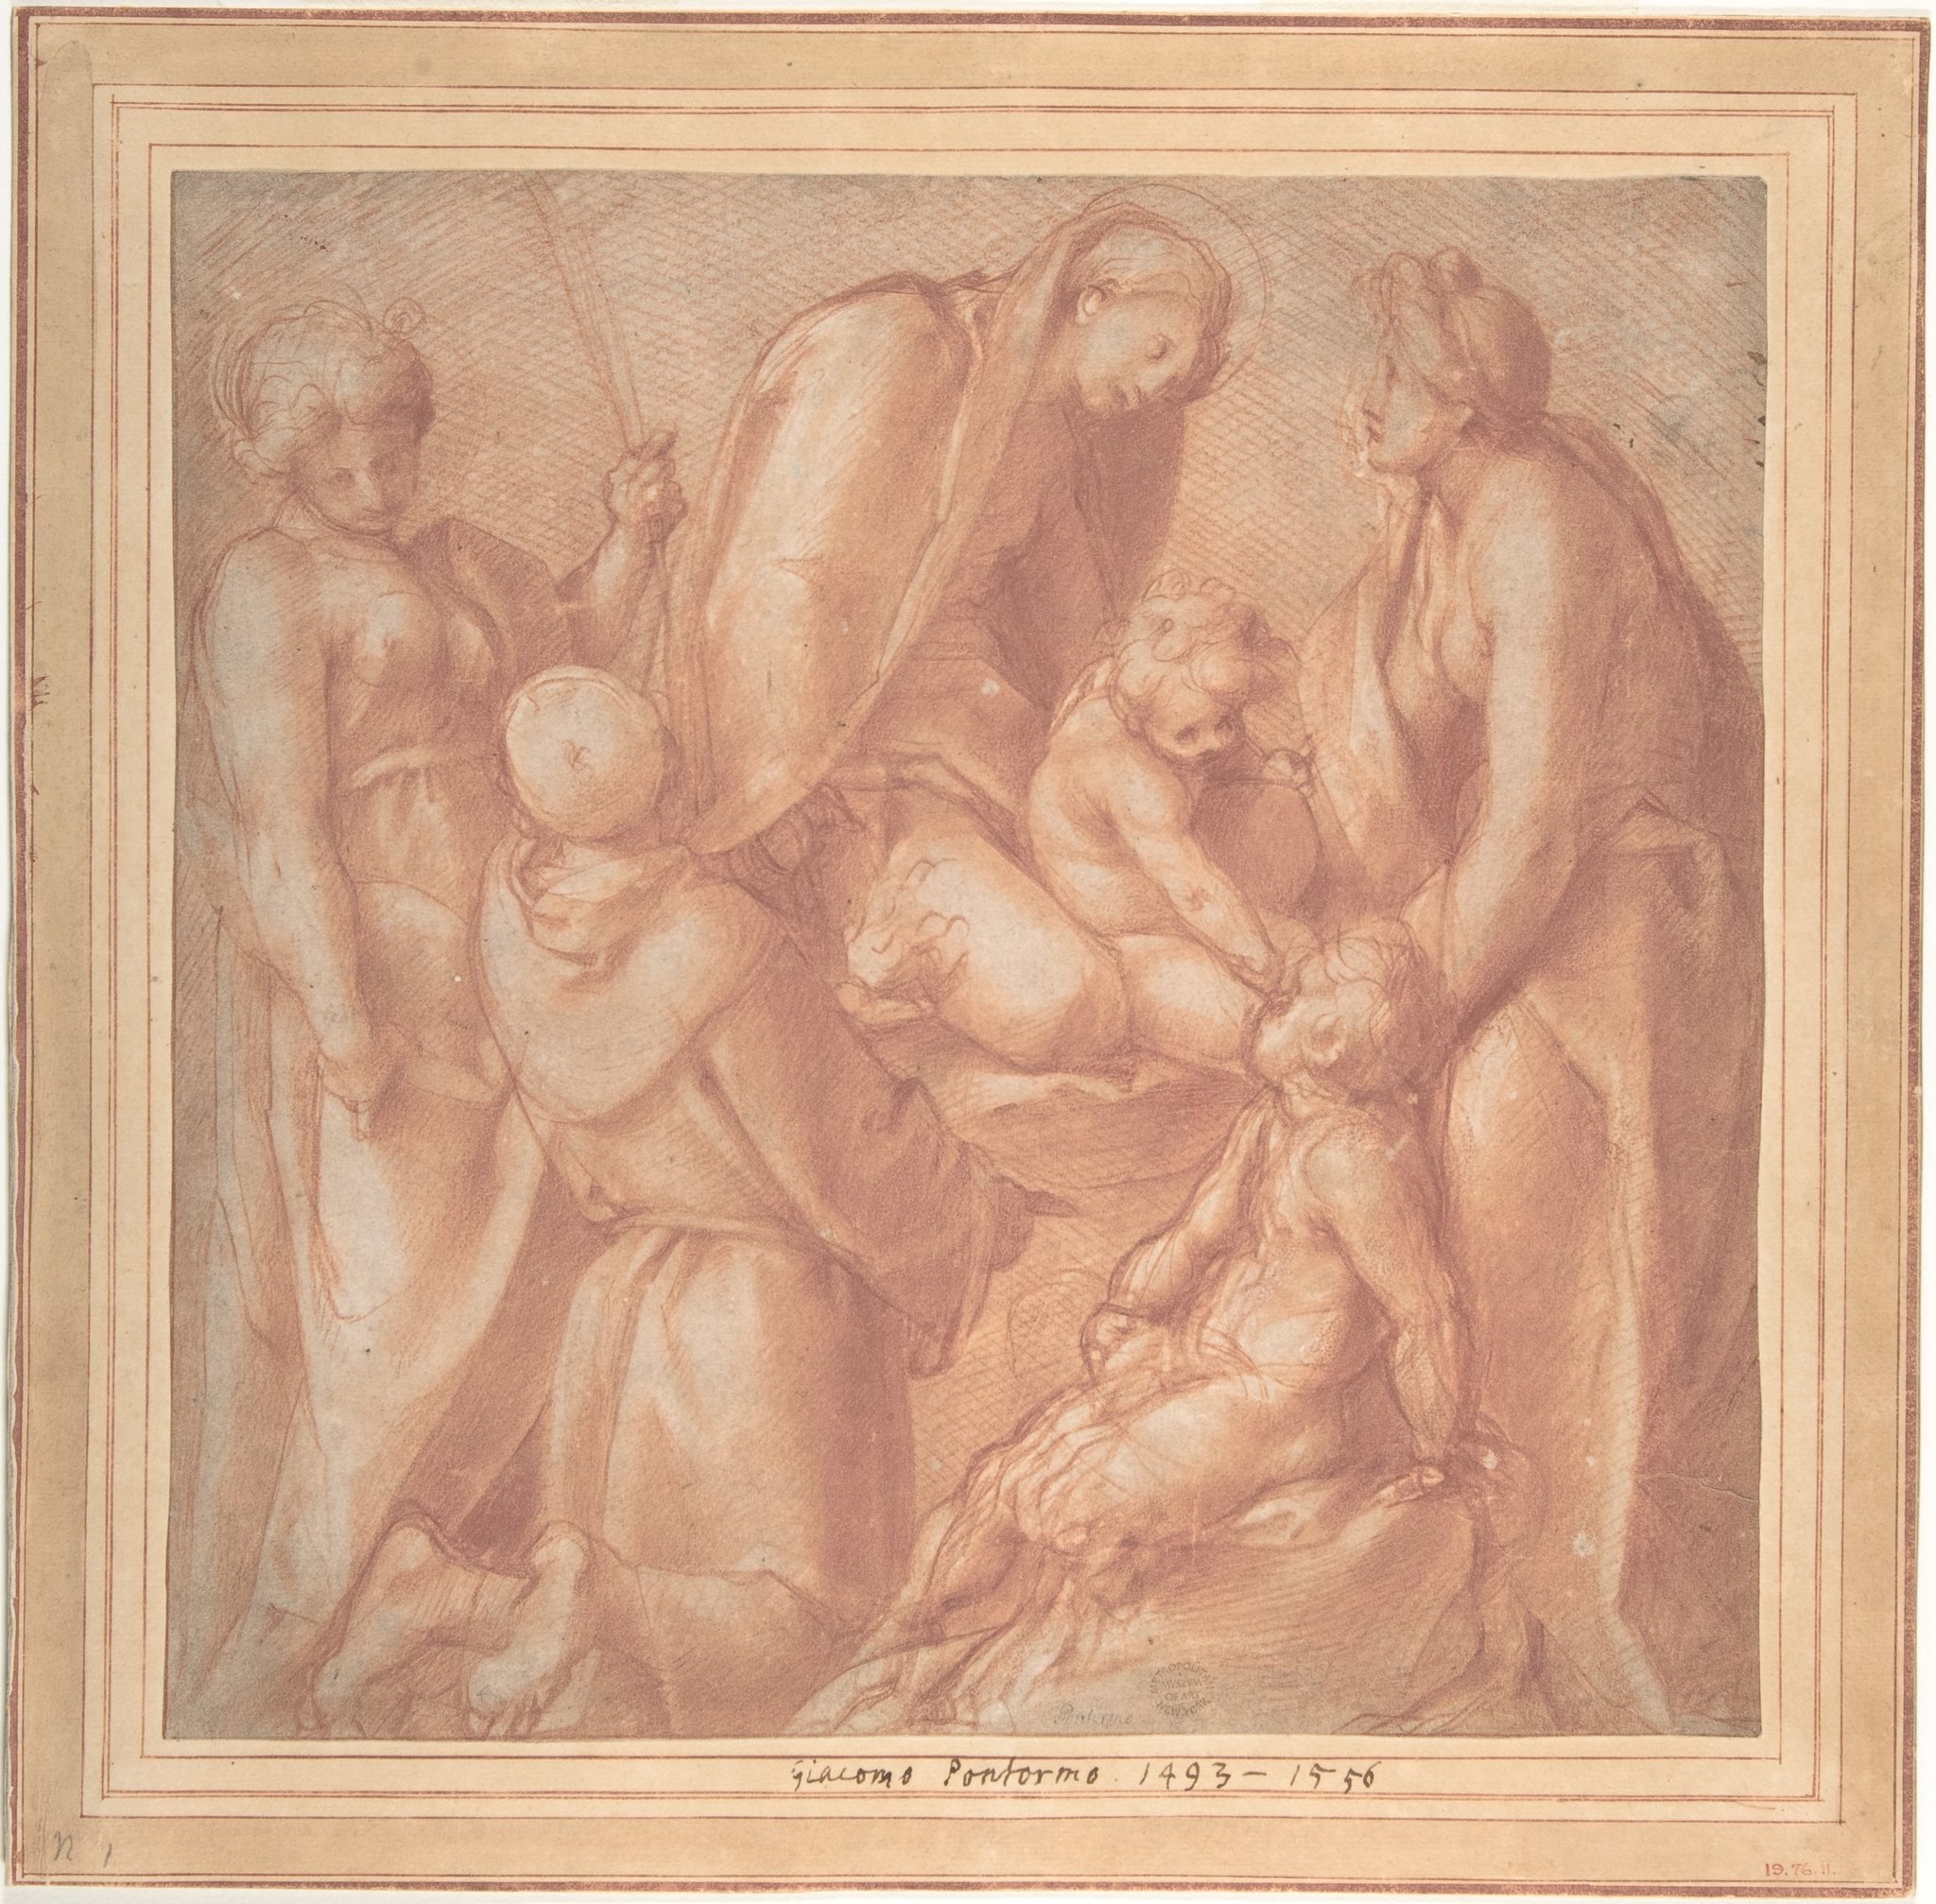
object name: drawing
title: Virgin and Child with Saint Elizabeth, the Infant Baptist, Saint Anthony of Padua, and a Female Martyr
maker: jacopo da pontormo (jacopo carucci)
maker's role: artist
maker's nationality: italian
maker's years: 1494-1556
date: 1514-1522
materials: chalk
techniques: brush, wash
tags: women,madonna and child,saint anthony,saints